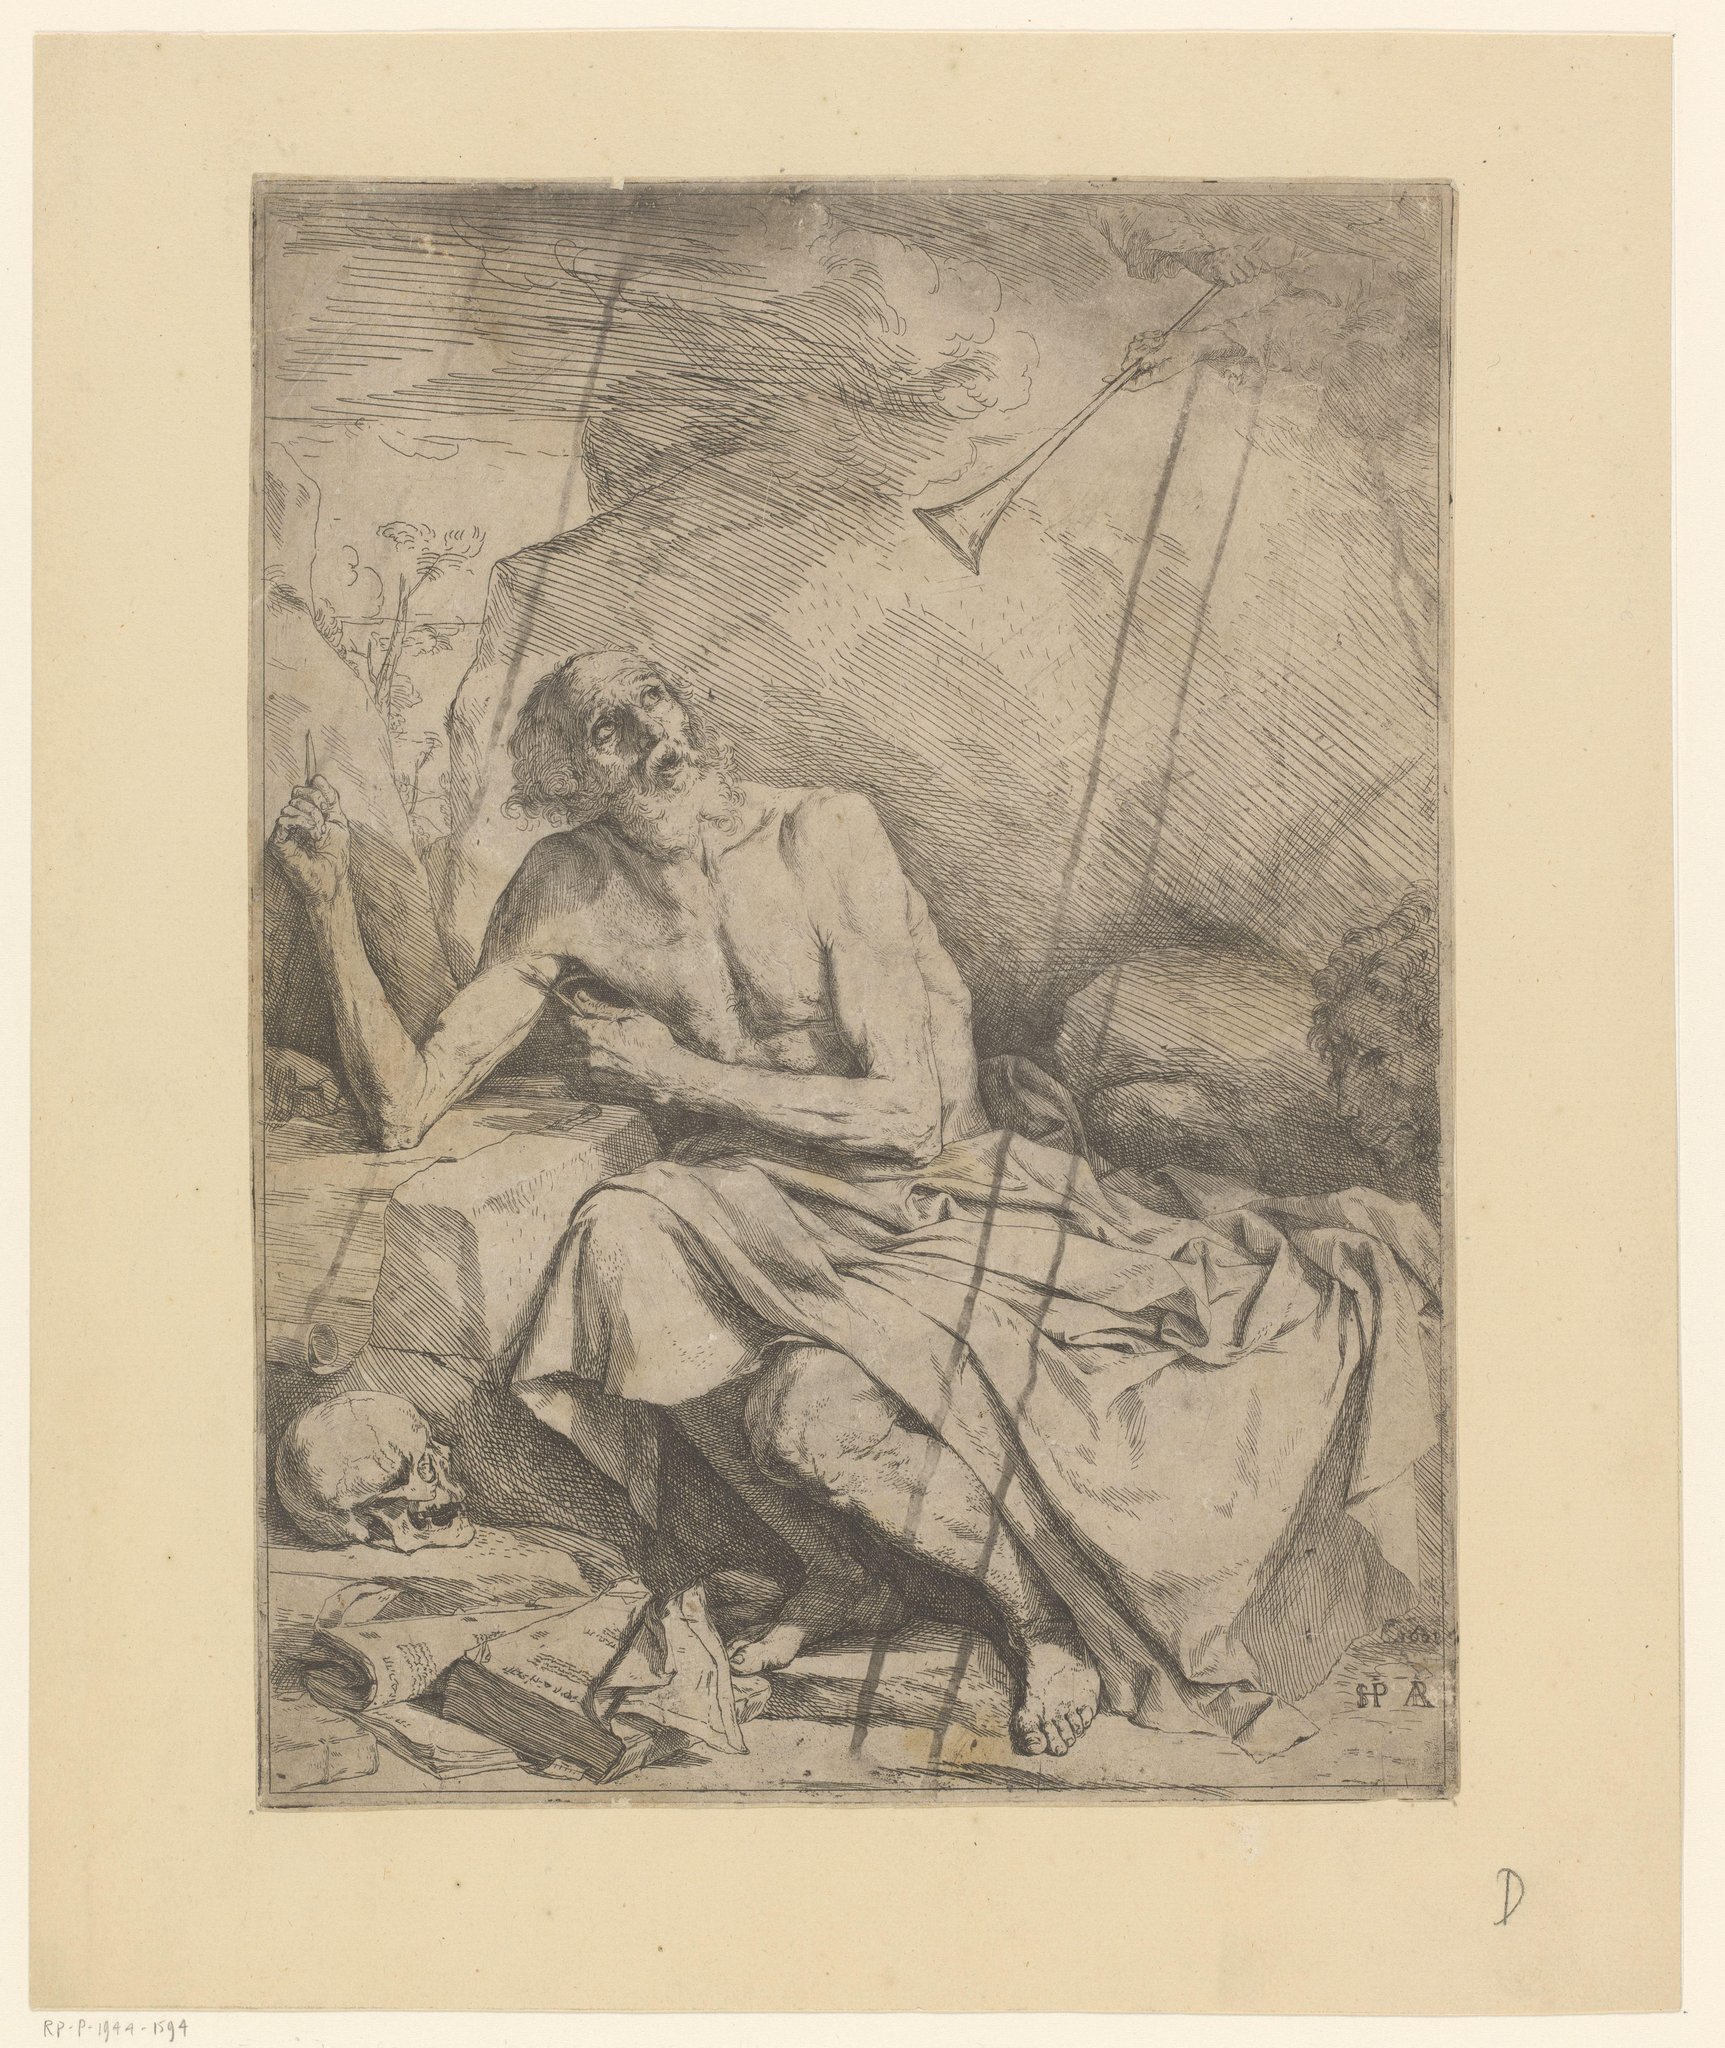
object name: print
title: Heilige Hieronymus en de trompet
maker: jusepe de ribera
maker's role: draughtsman, painter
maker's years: 1591-1652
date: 1621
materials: paper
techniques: drypoint, engraving, etching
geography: naples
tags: st. jerome listens to angels blowing the trumpets of the last judgement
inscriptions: collector's mark: Lugt 2228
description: De heilige Hieronymus zittend in de wildernis, met zijn boeken, een schedel en de leeuw. Uit een wolk aan de hemel steken twee handen die een trompet vasthouden.